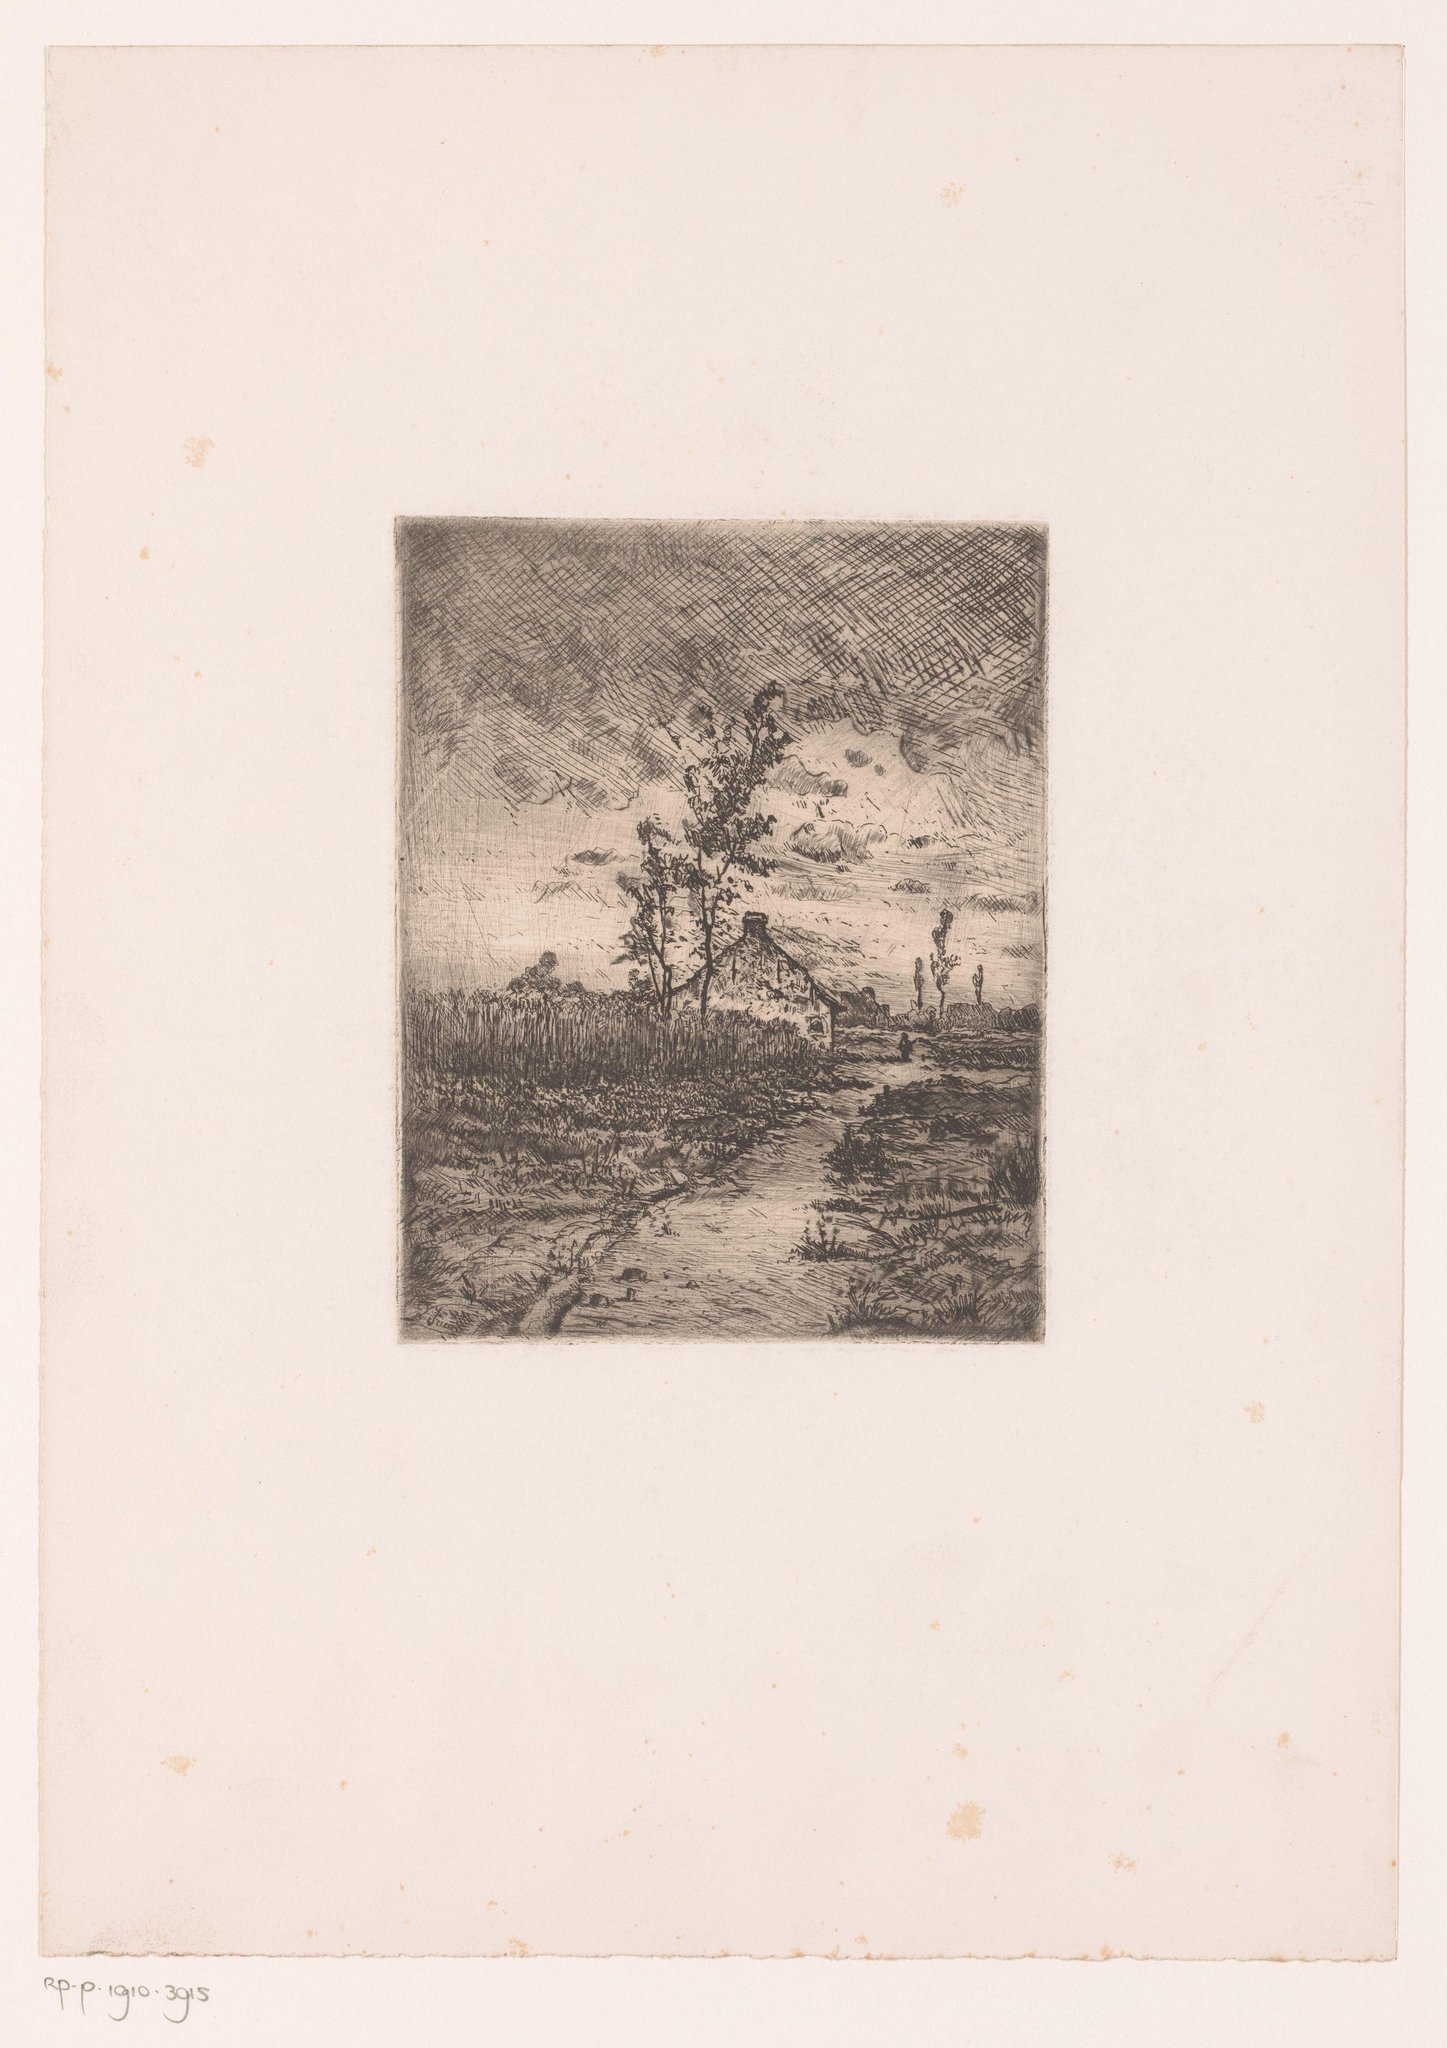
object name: print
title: Landschap met boerderij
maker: louis adolphe jacobs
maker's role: painter, print maker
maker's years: 1855-1929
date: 1865-1910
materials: paper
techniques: etching, intaglio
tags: farm or solitary house in landscape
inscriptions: collector's mark: Lugt 2228